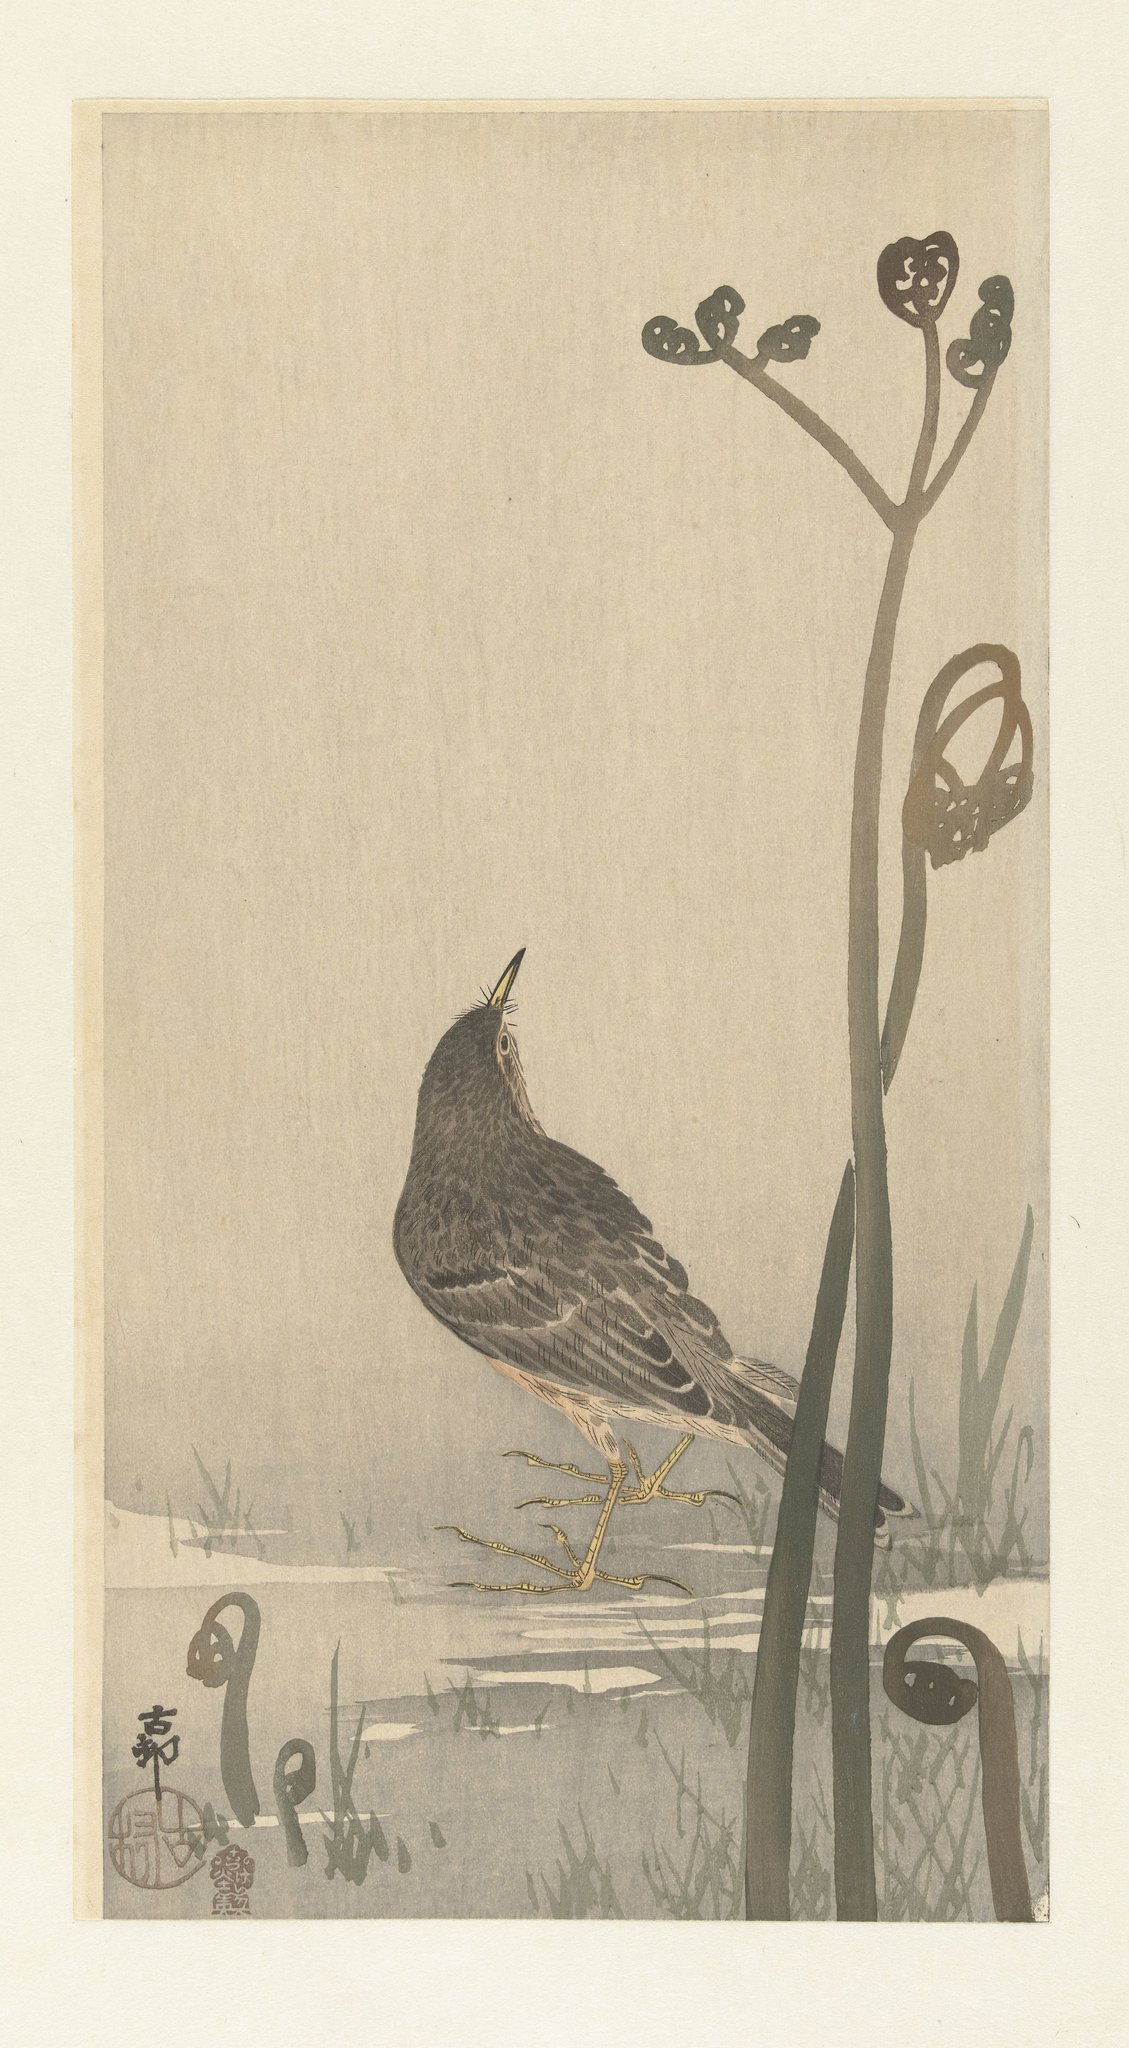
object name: print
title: Pieper aan waterkant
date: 1900-1910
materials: paper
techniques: woodcut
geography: japan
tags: ferns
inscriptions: collector's mark: Lugt 2228